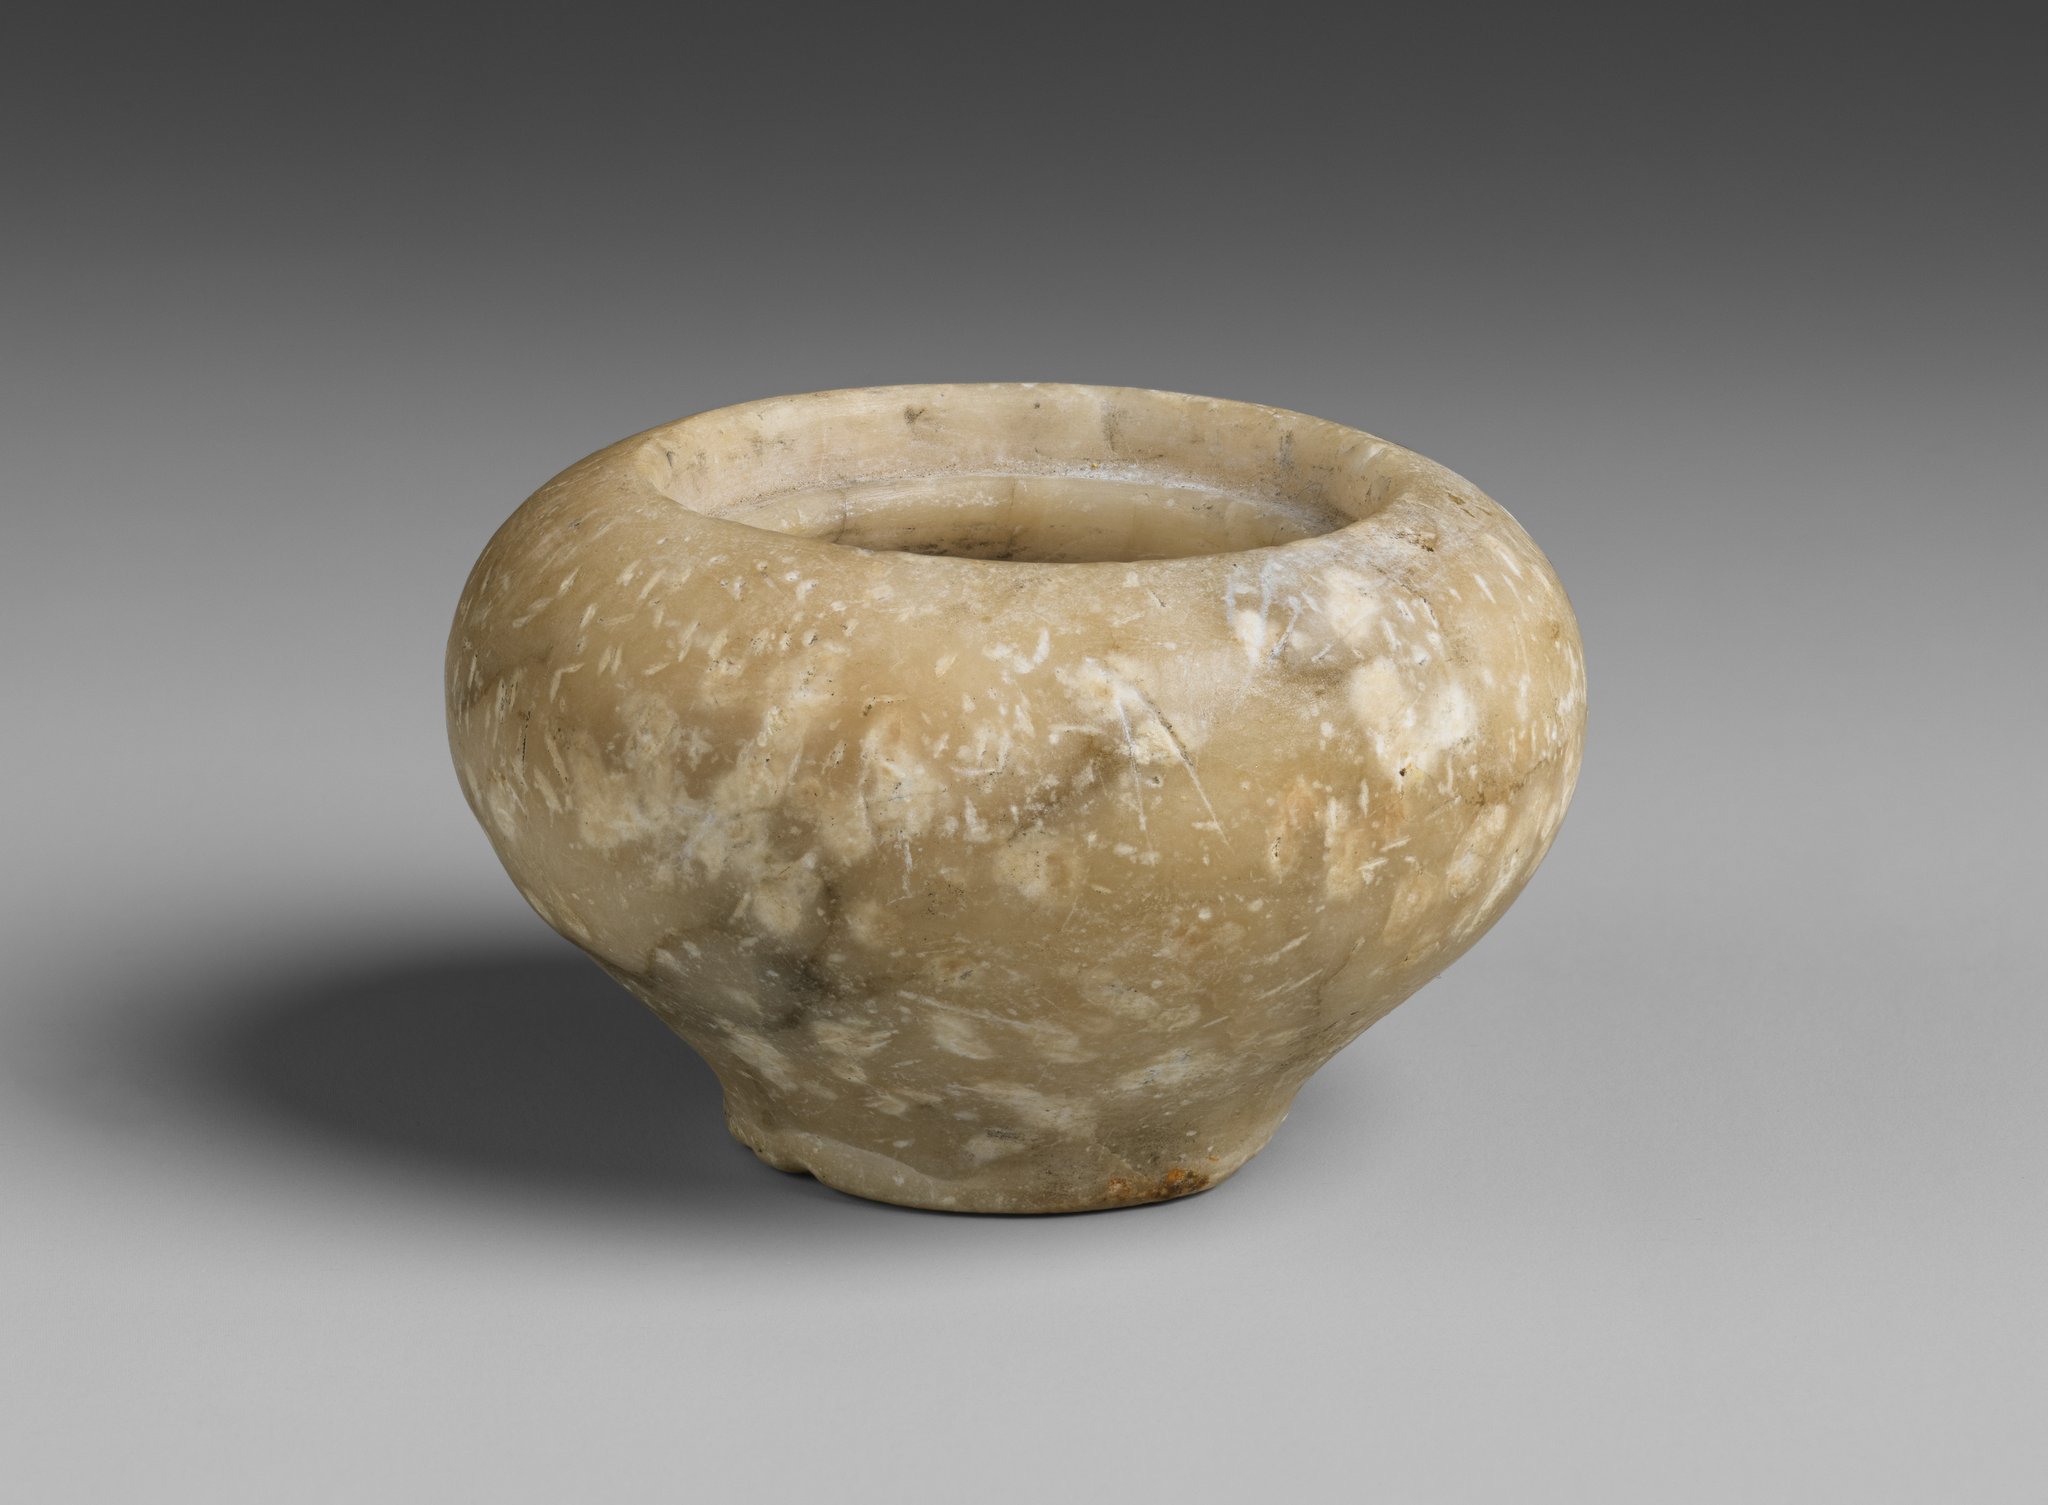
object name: bowl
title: Alabaster bowl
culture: minoan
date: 2000-1800 BCE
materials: alabaster